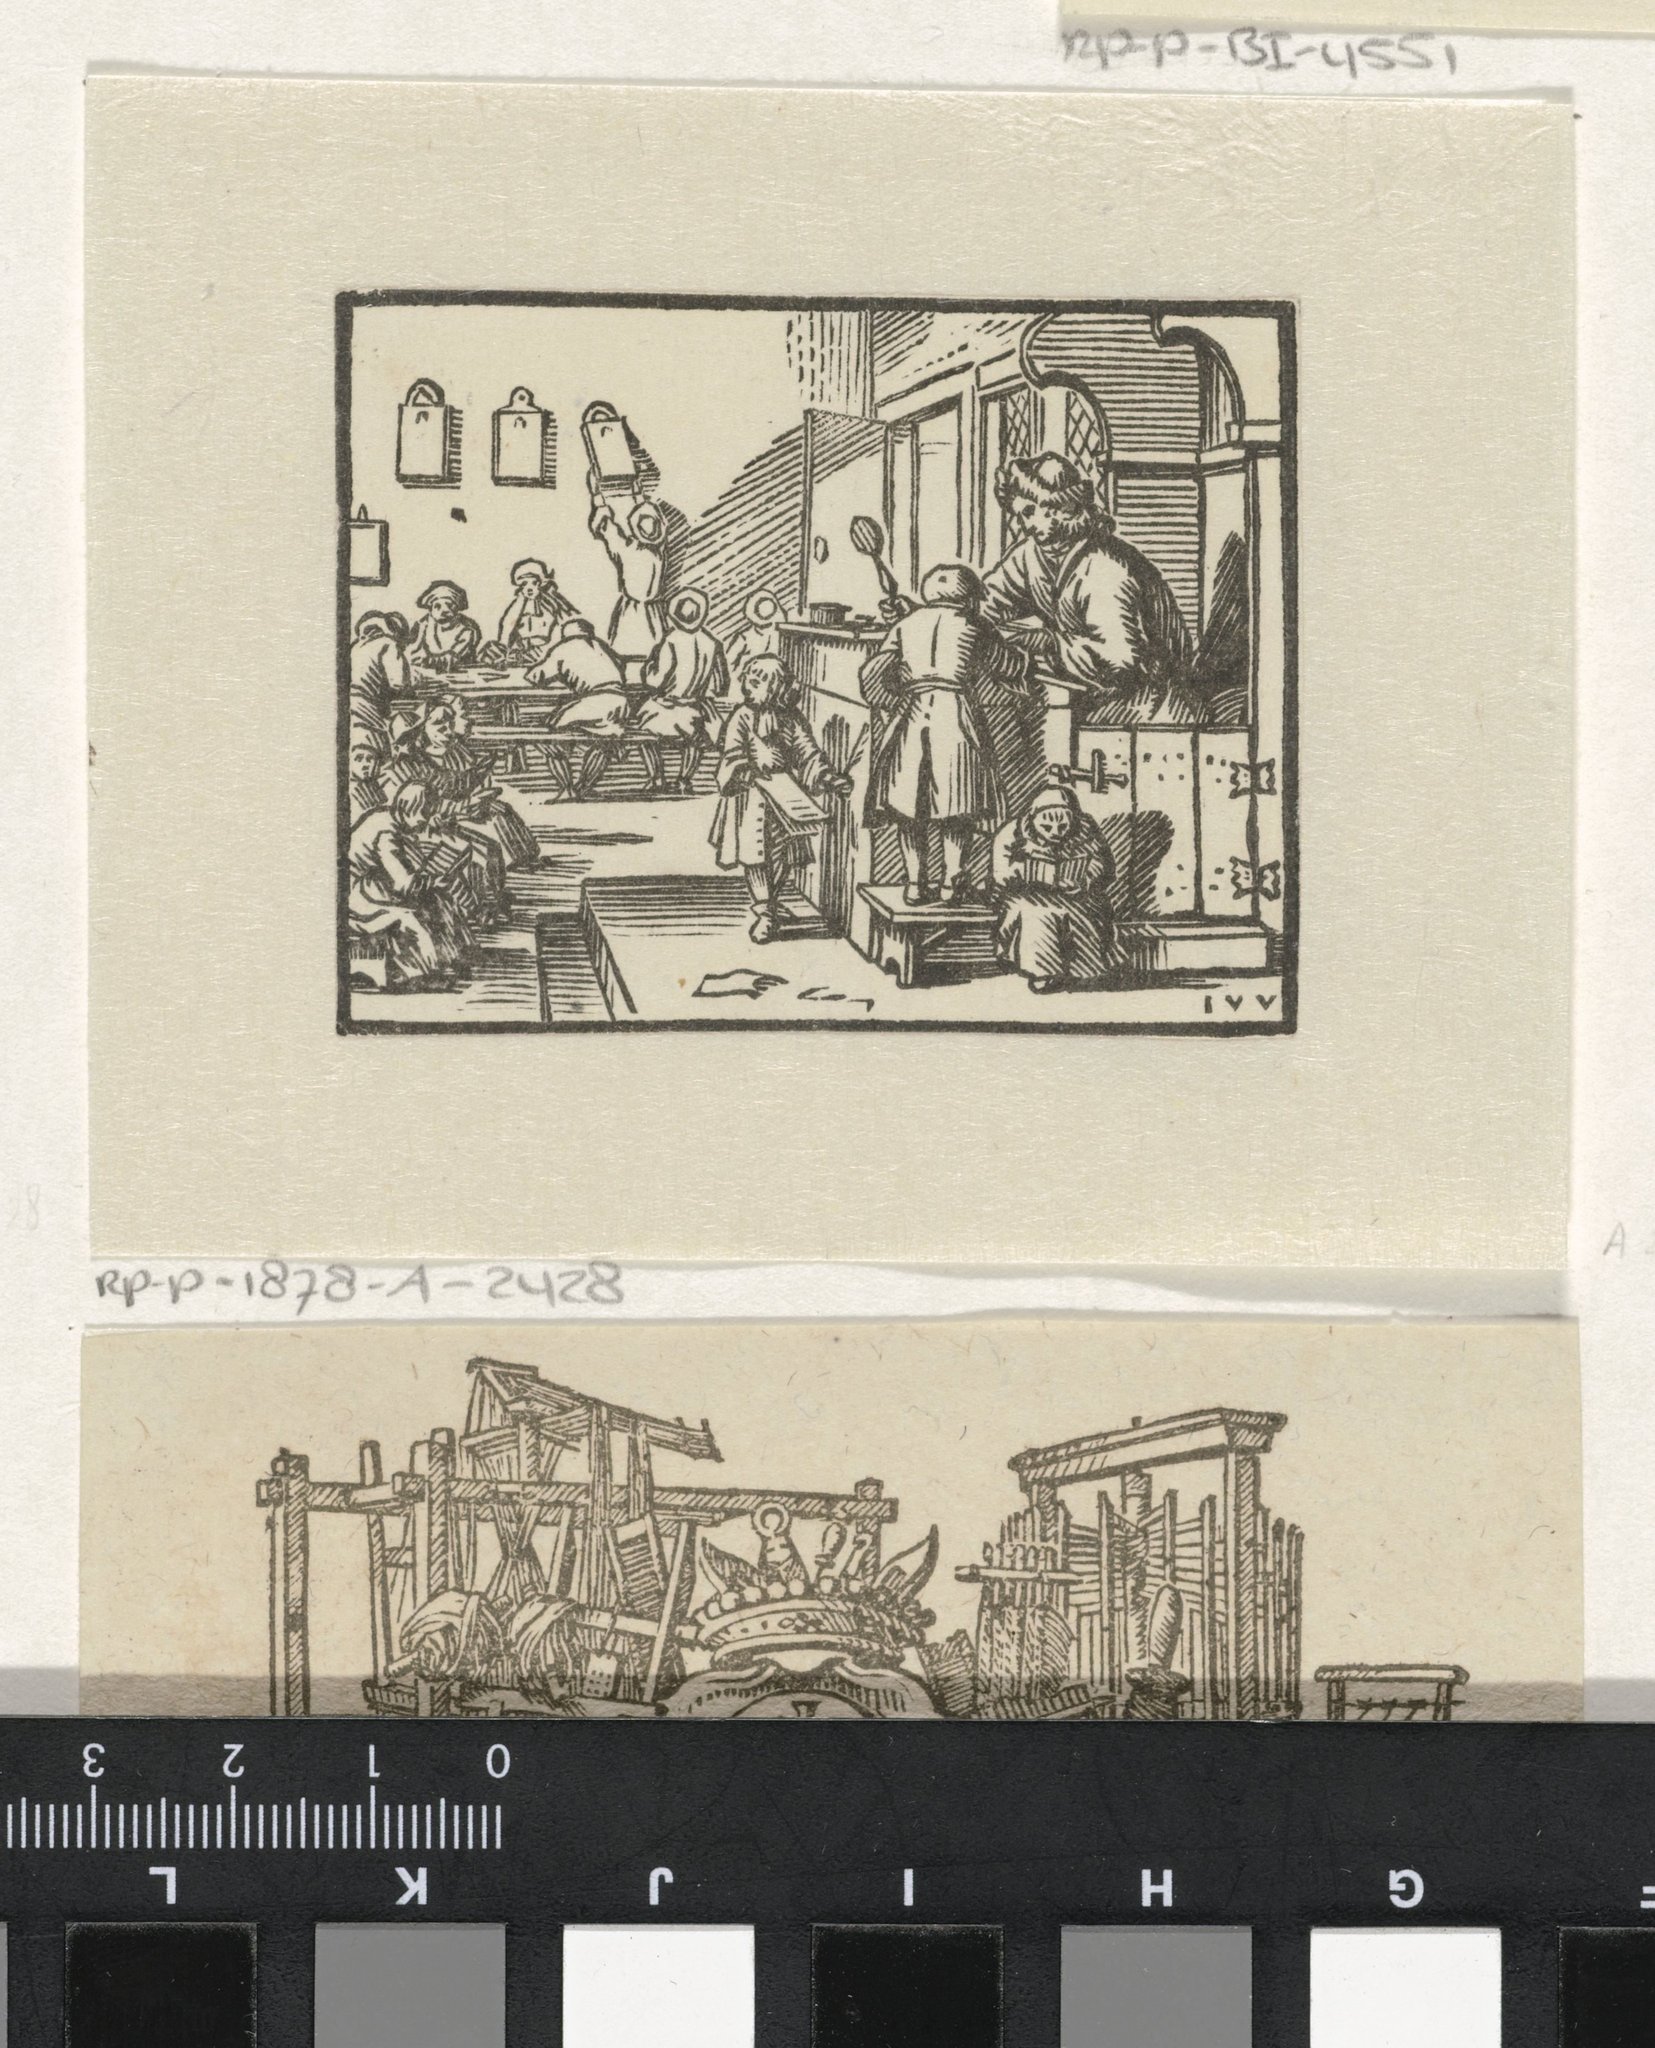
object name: print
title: Schoolklas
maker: isaac vincentsz. van der vinne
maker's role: draughtsman, print maker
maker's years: 1665-1740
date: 1681-1740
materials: paper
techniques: woodcut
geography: haarlem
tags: teacher and pupil